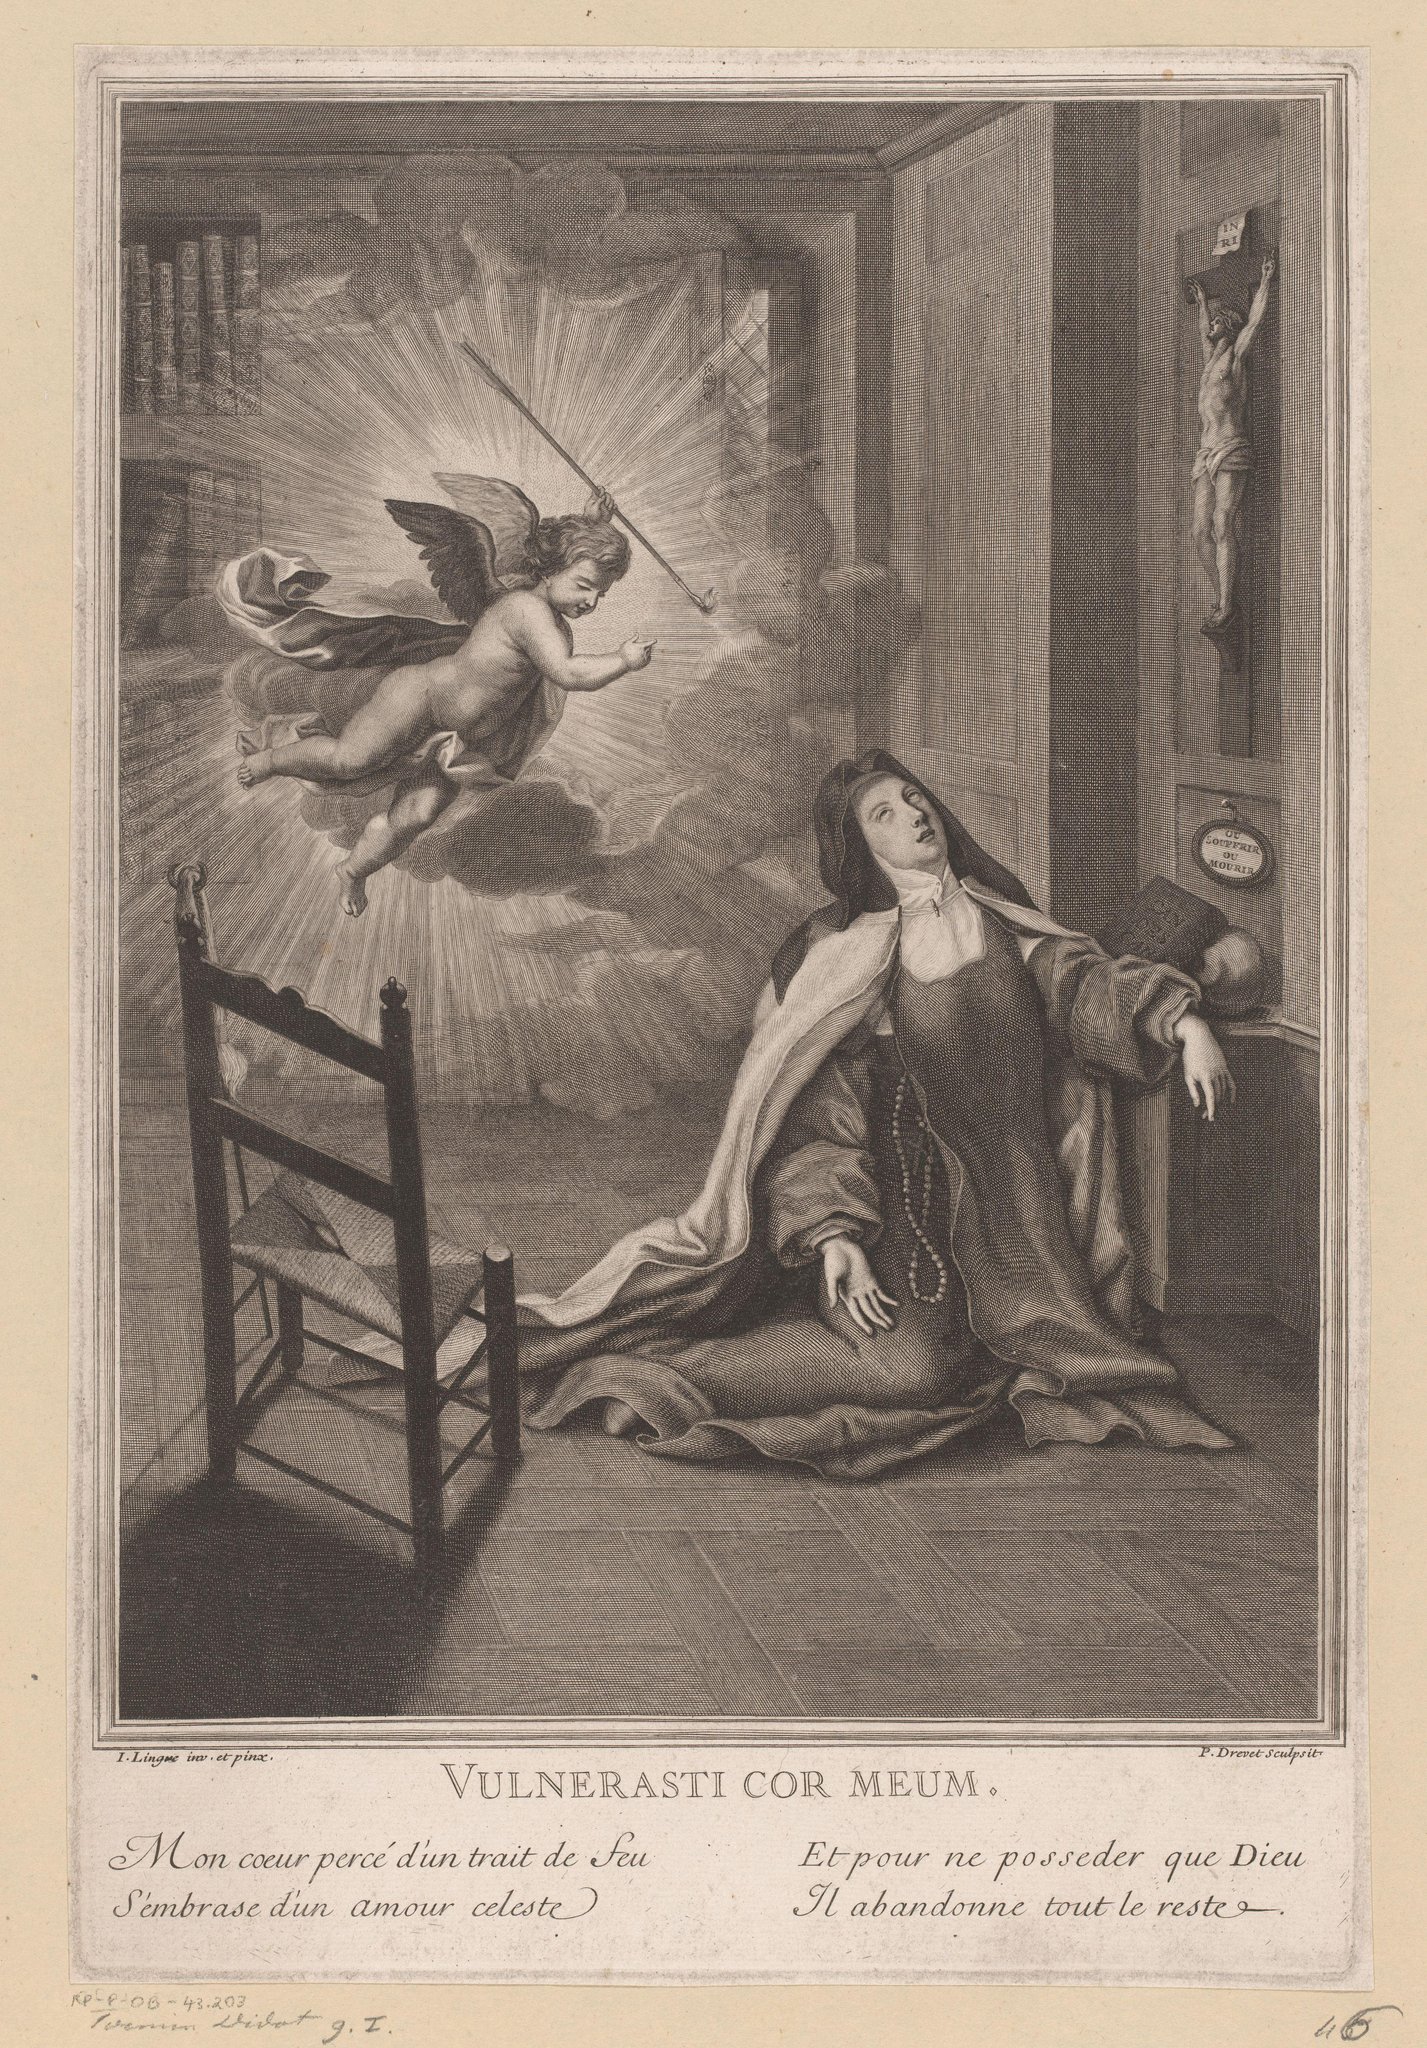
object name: print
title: H. Theresia in extase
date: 1707-1739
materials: paper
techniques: engraving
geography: france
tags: personal devotion of st. theresa - female saint meditating, in ecstasy, private worship and religious study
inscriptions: collector's mark: Lugt 240